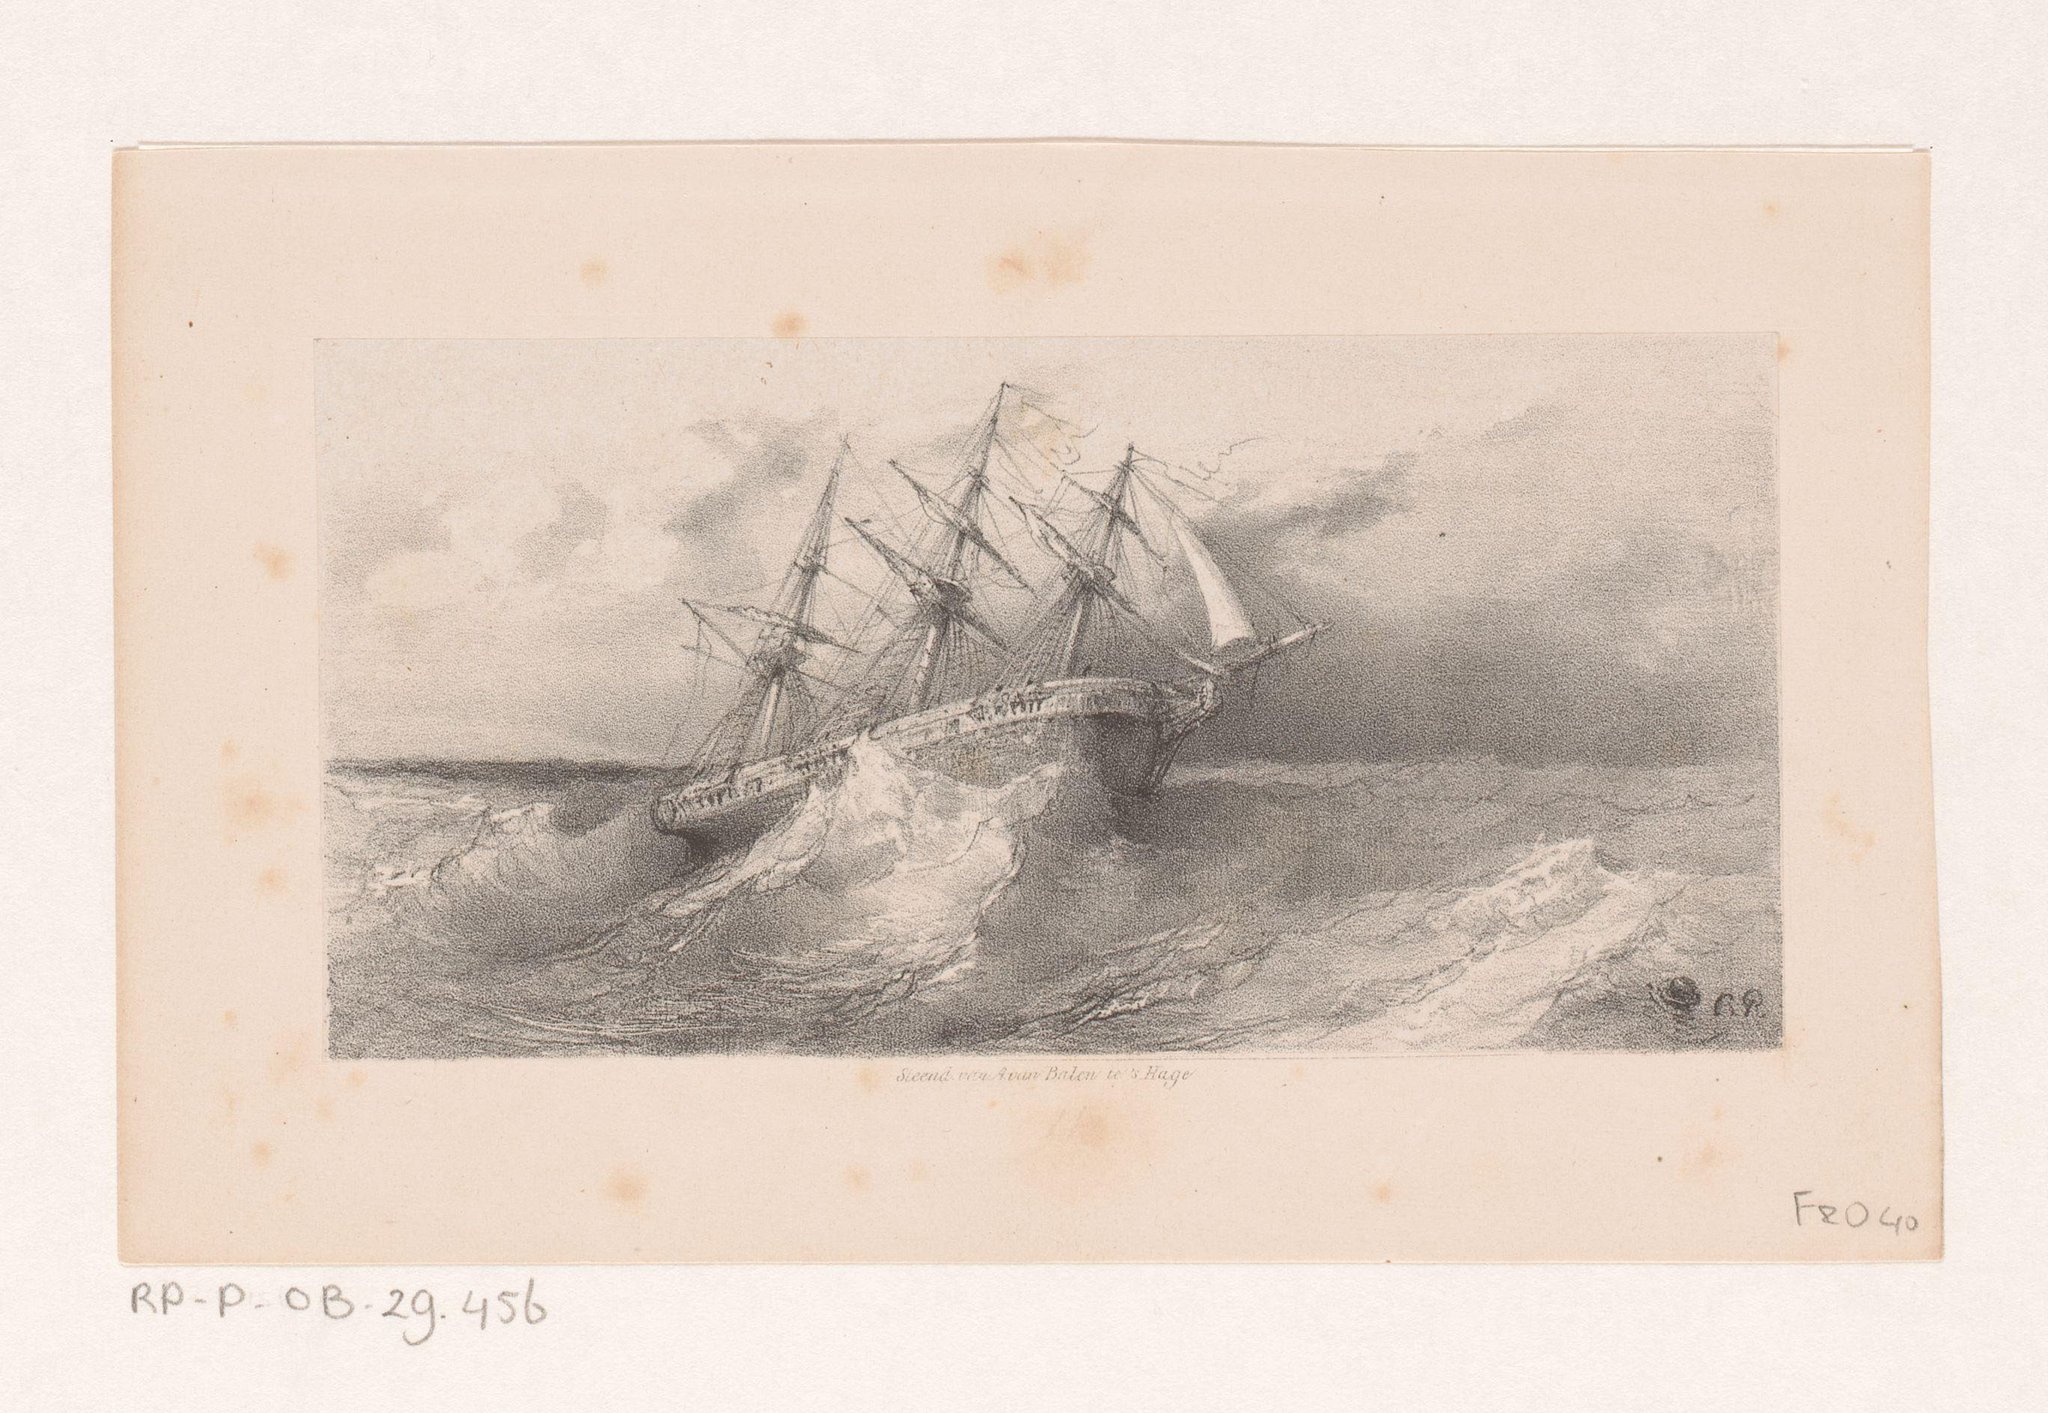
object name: book illustration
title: Zeilschip in storm op zee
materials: paper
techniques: lithograph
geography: the hague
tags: sailing-ship, sailing-boat, storm at sea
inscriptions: collector's mark: Lugt 2228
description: Prent uit: Raspe, Rudolf Erich. Zonderlinge reizen en lotgevallen van den Vrijheer von Münchhausen. Den Haag: Bisschop, J.H., 1843.